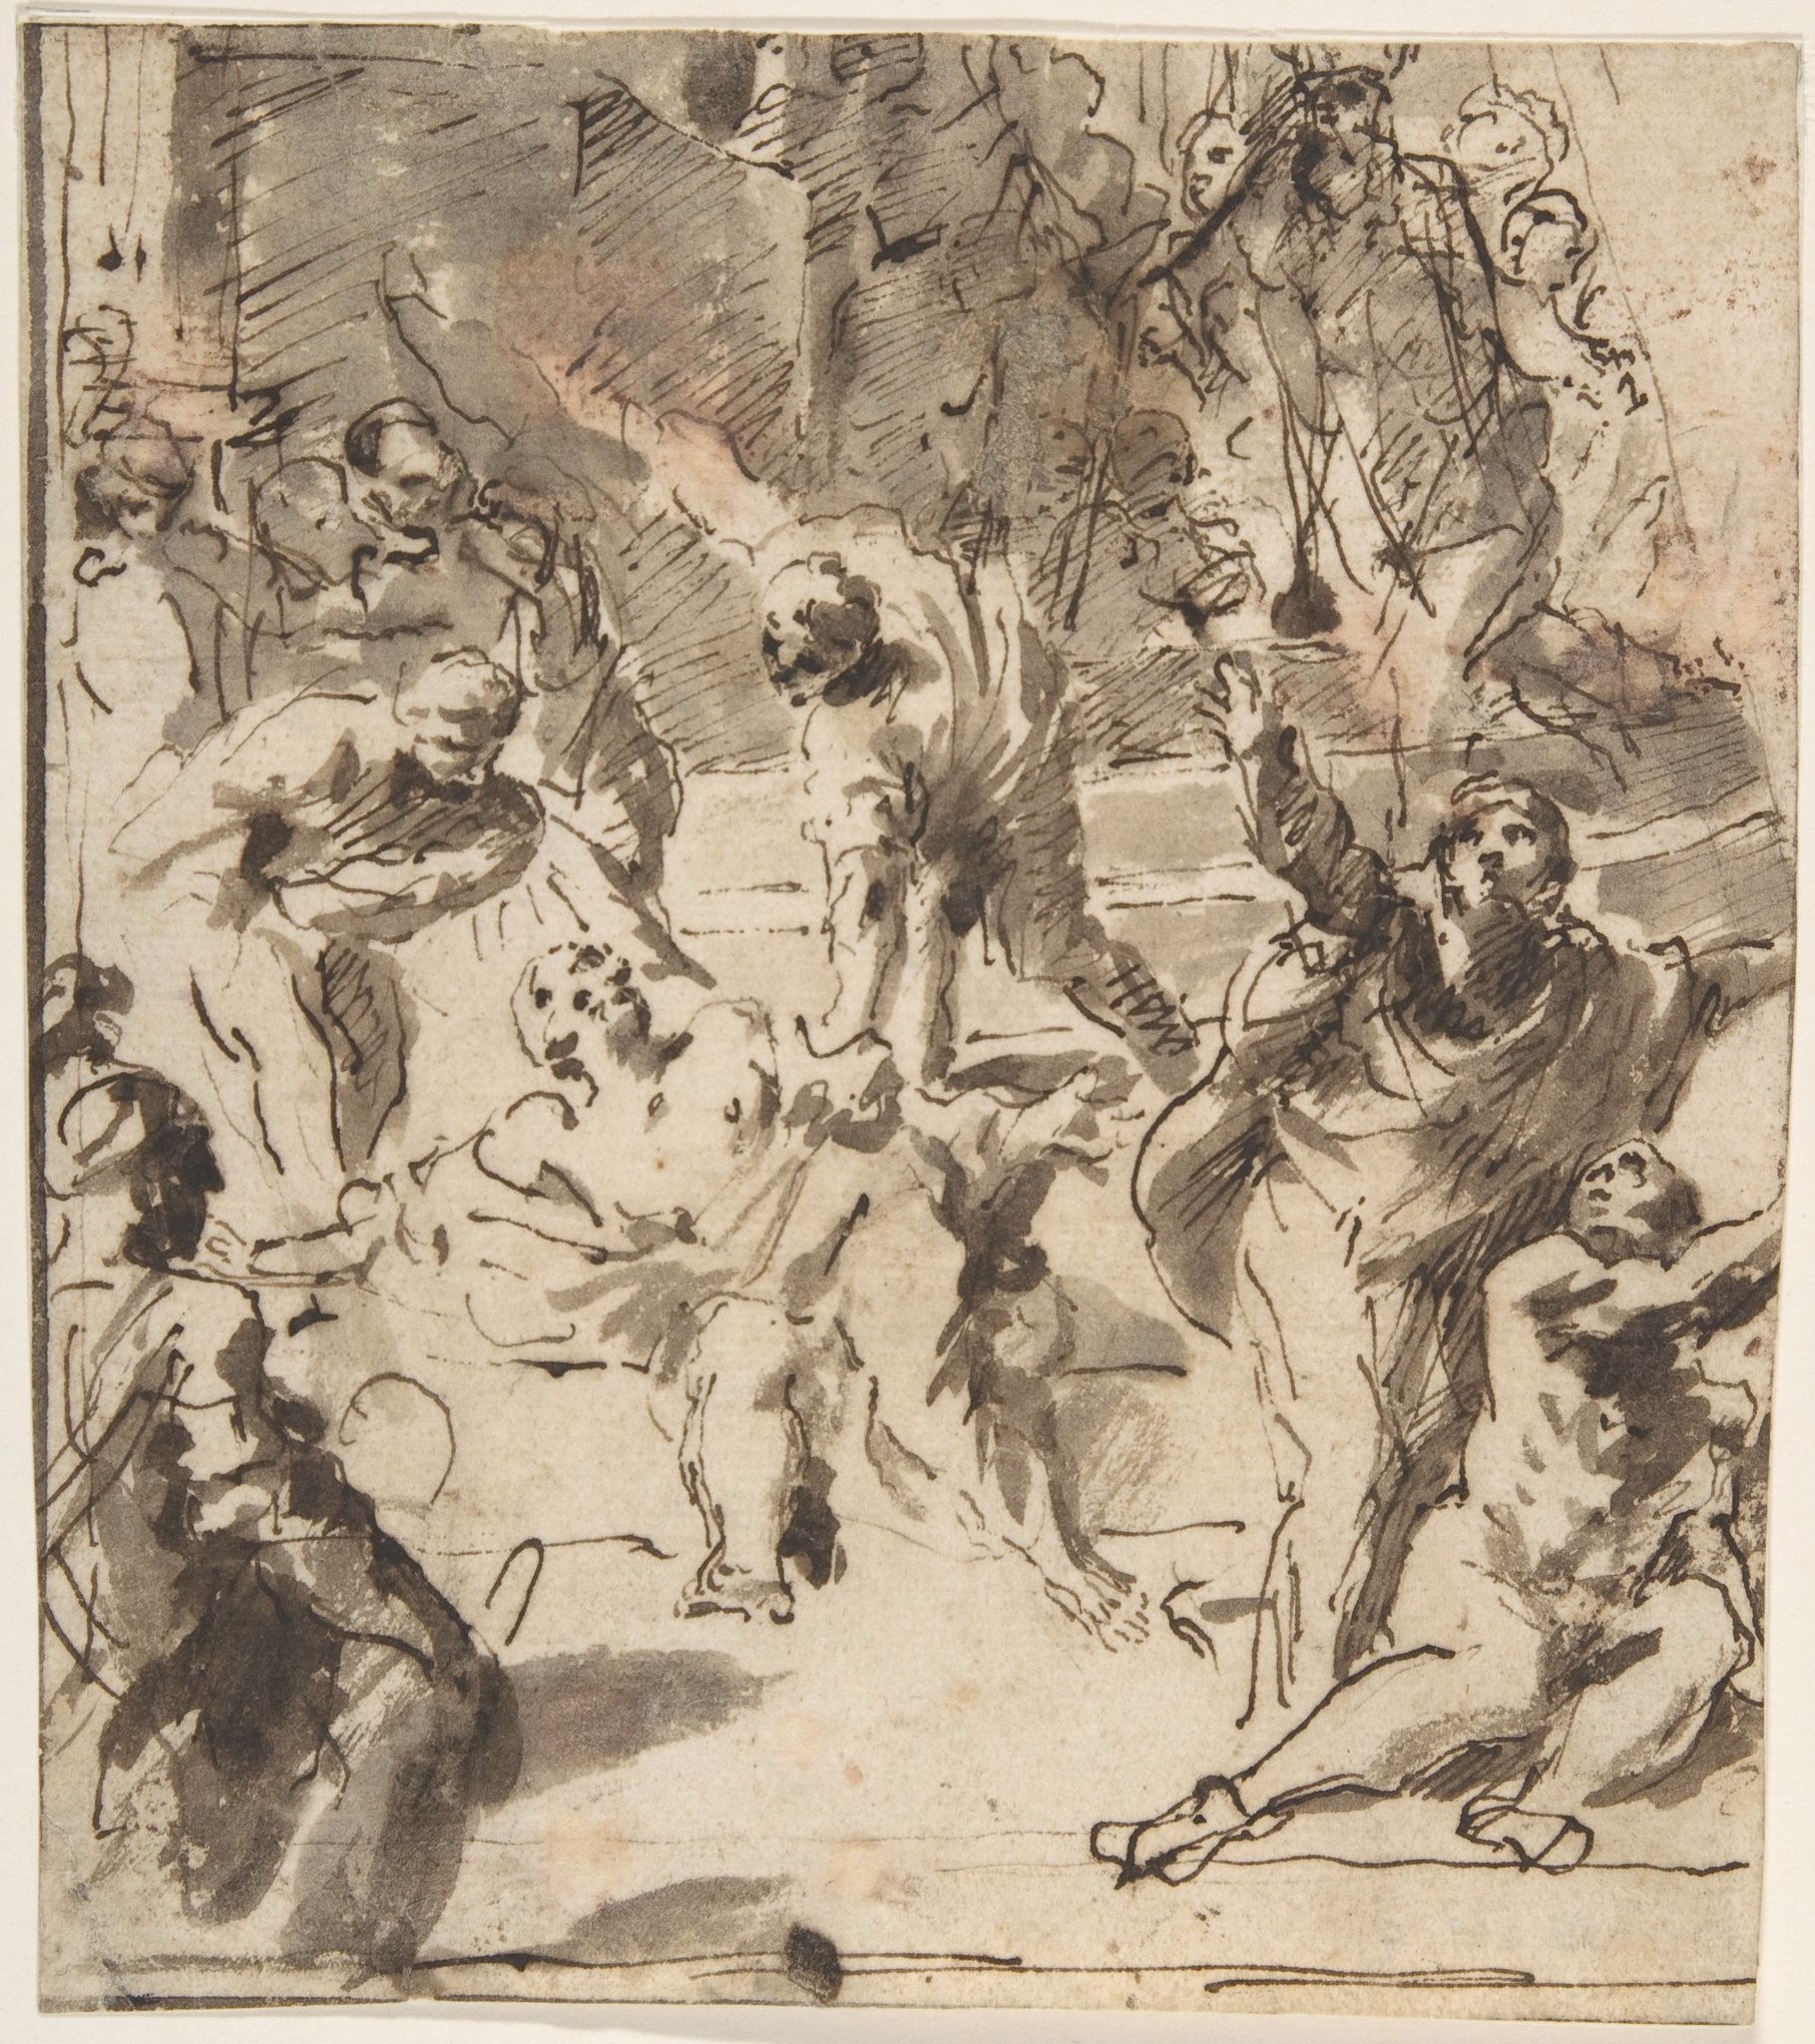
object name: drawing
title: The Martyrdom of the Apostle Thomas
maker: giovanni lanfranco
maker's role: artist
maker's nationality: italian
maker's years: 1582-1647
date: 1638-1646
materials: ink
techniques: brush, pen, wash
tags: interiors,men,apostles,saints,death